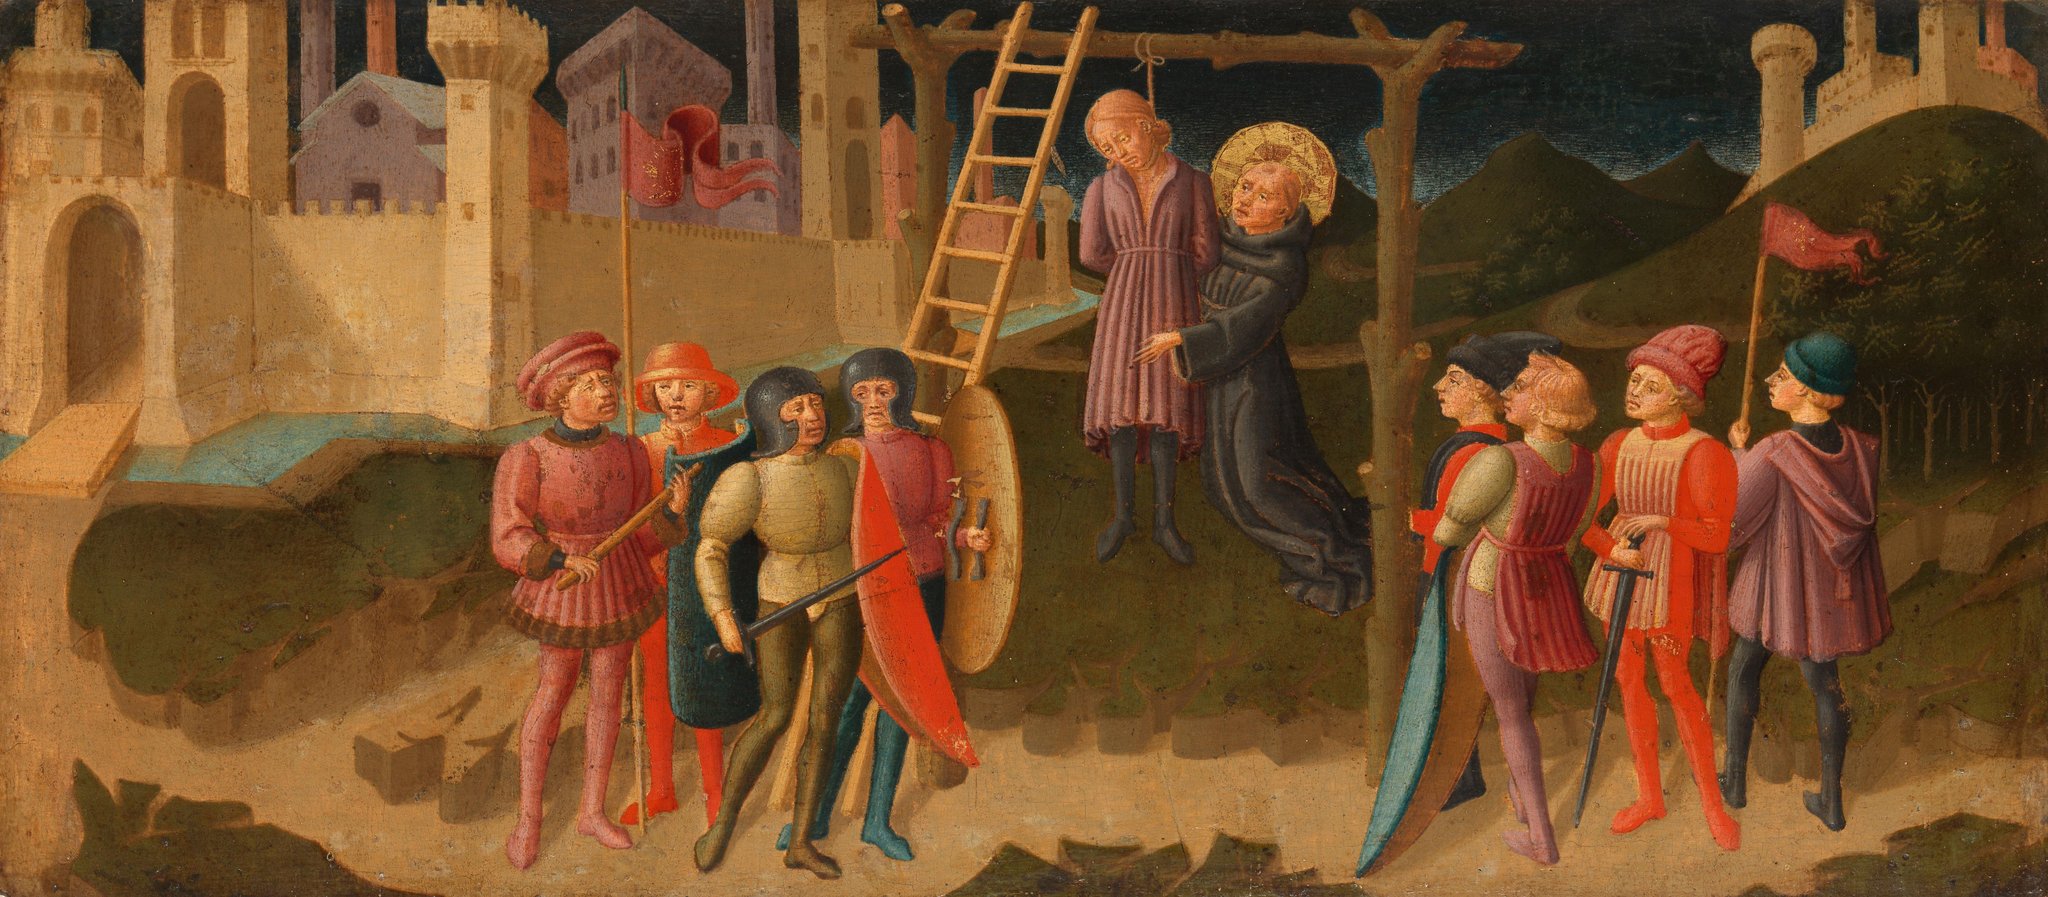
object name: painting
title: Saint Nicholas Saving a Hanged Man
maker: zanobi di jacopo machiavelli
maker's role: painter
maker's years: 1418-1479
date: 1470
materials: panel, paint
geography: florence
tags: st. nicholas of tolentino holding up a hanged man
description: The panel depicts one of the many miracles of Saint Nicholas, whose charity is still widely celebrated on 5 December. It was originally a predella (a small panel at the base of an altarpiece) that formed part of a triptych devoted to the saint in the church of Santo Spirito in Florence.